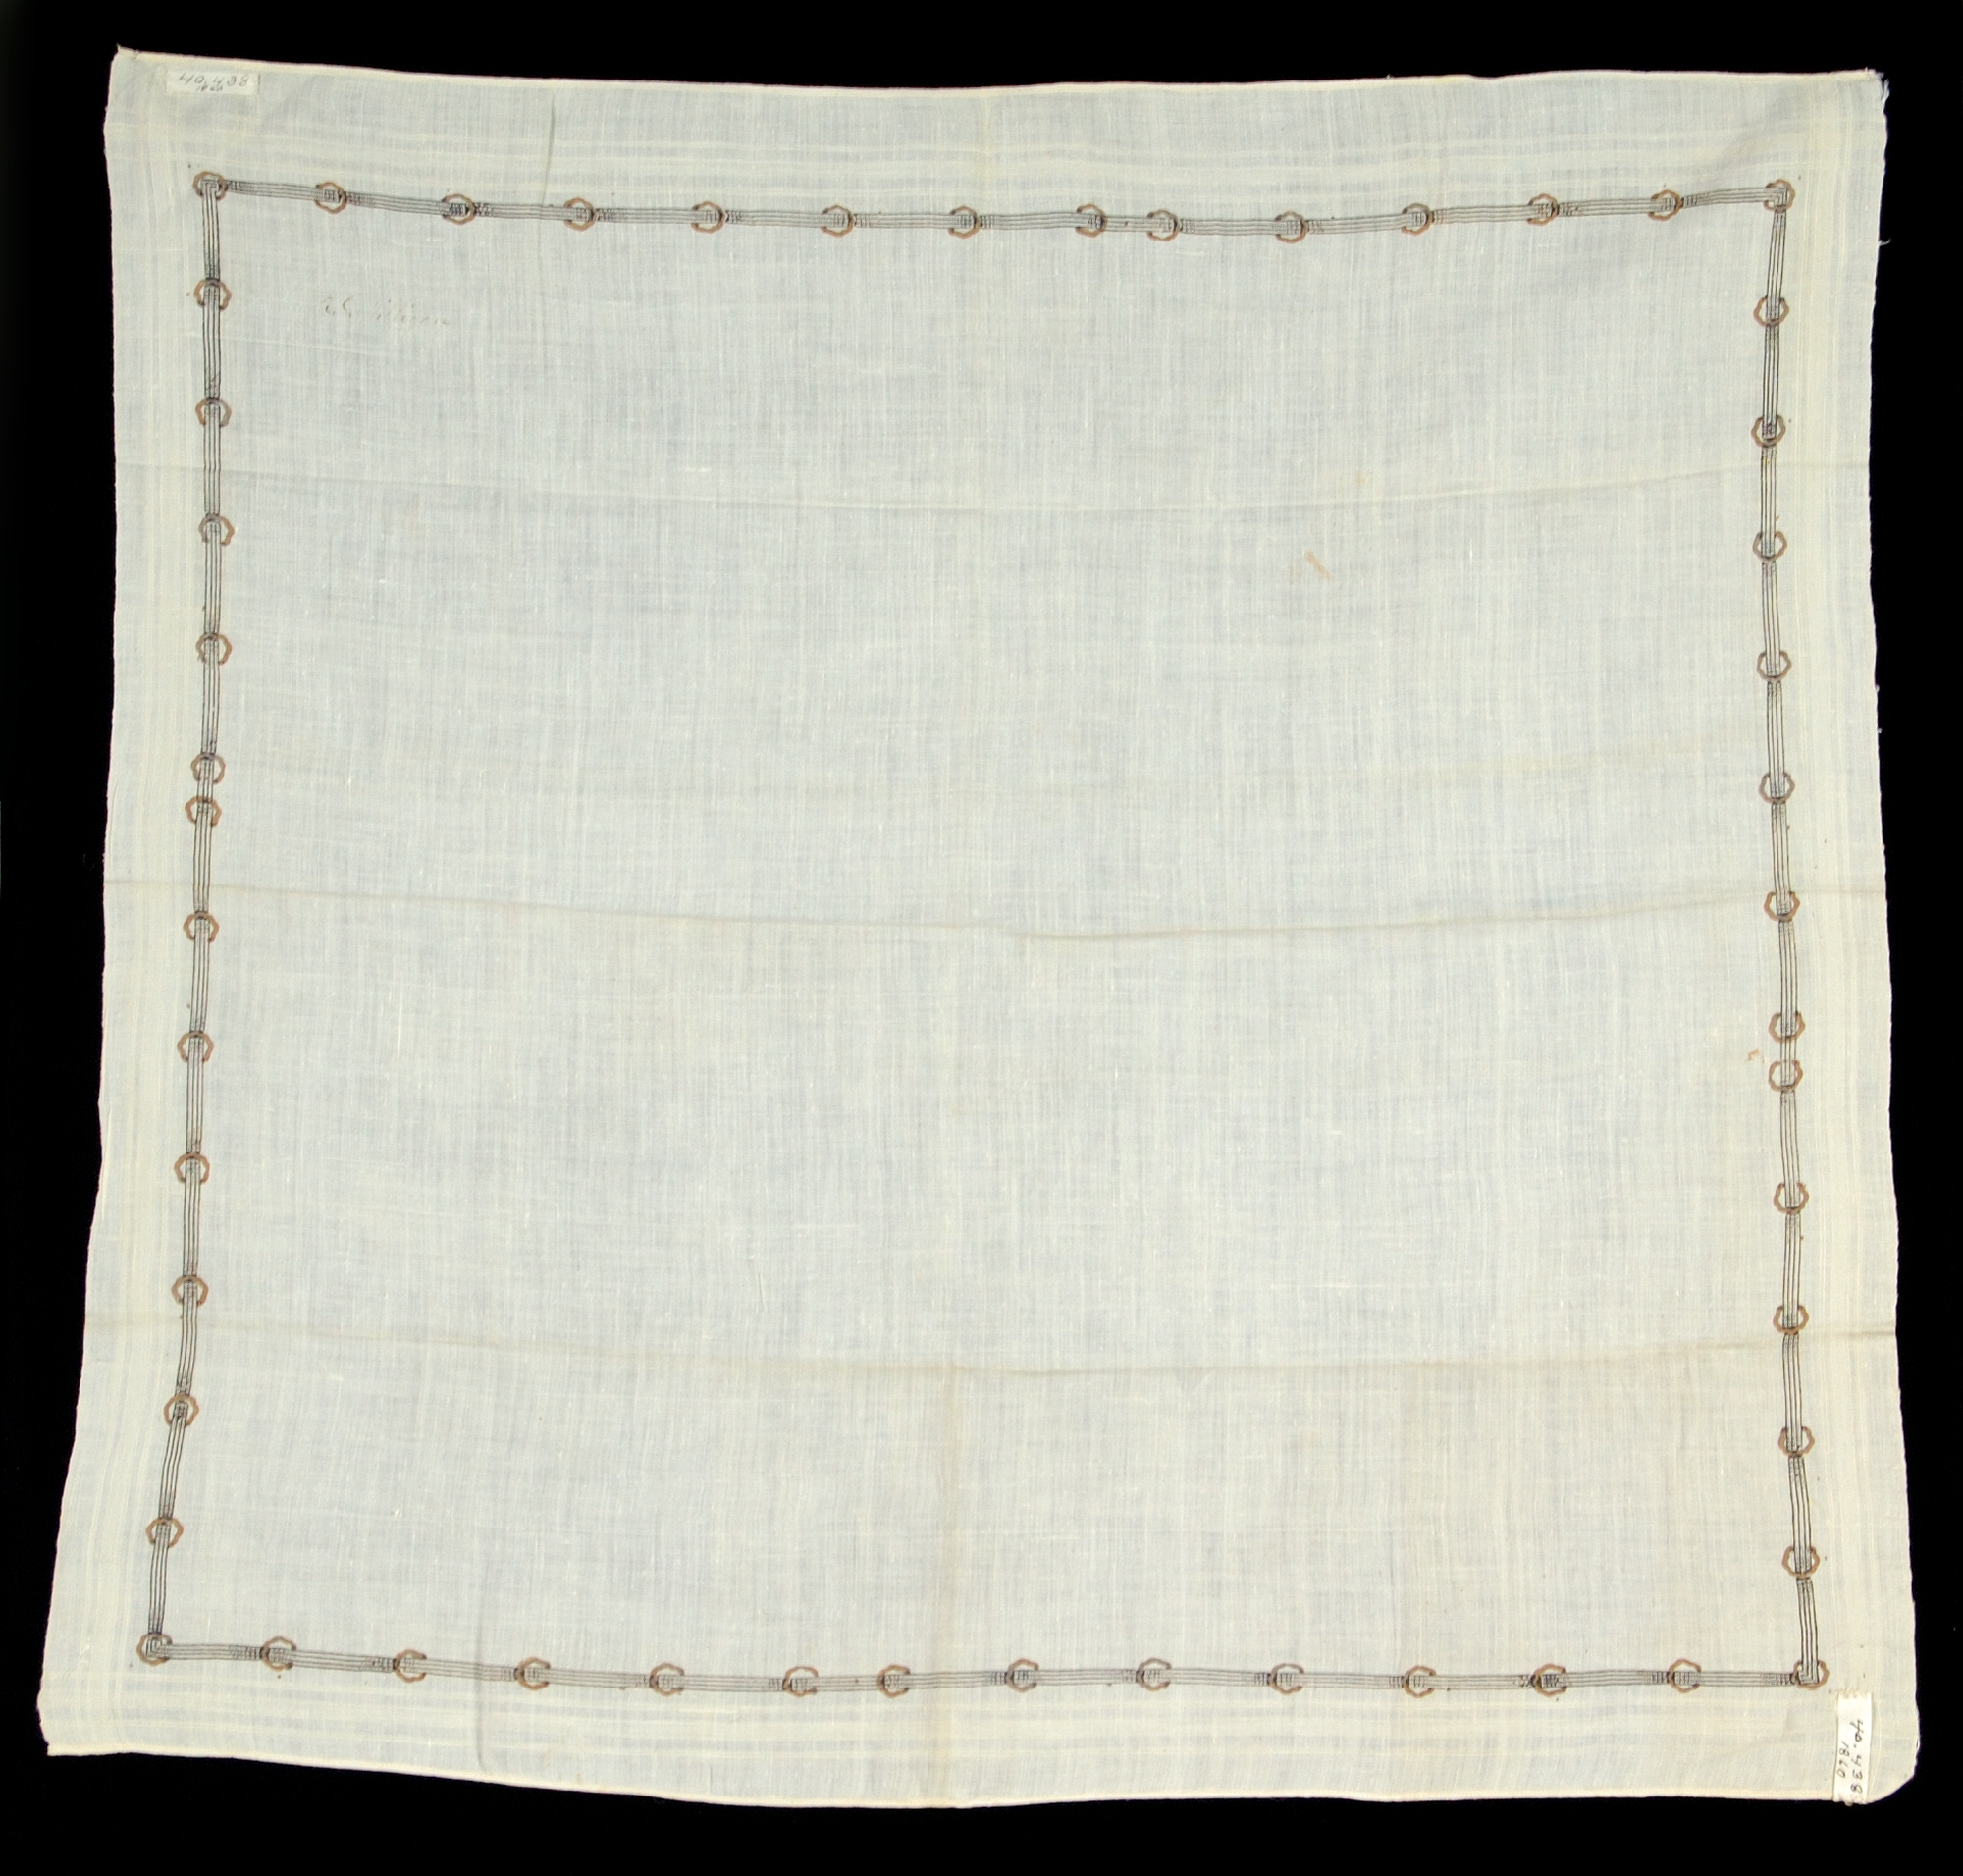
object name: handkerchief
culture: american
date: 1860-1870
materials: linen